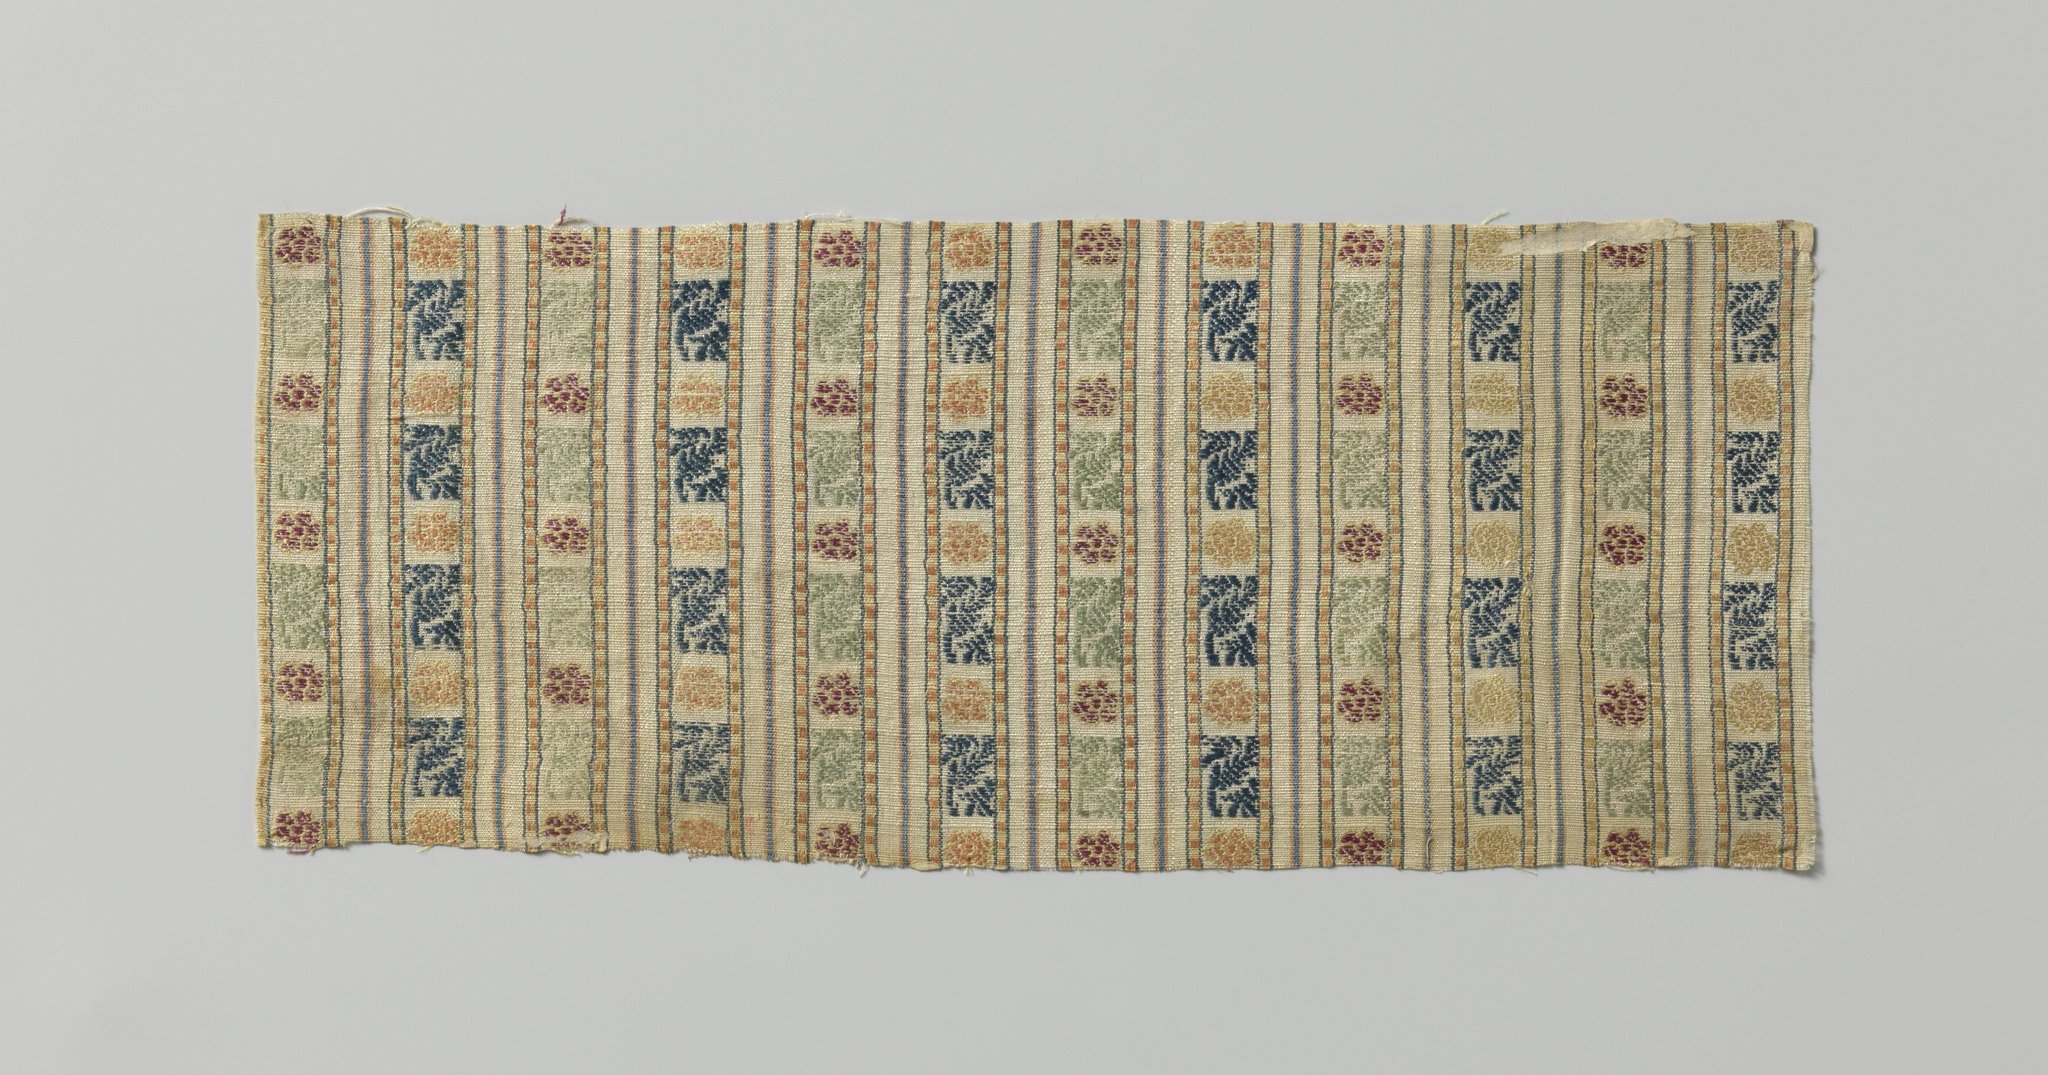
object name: fragment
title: Fragment Oosterse textiel met een veelkleurig gestreept patroon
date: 1800-1850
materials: cotton, silk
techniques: brocade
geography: india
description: Fragment Oosterse textiel met een veelkleurig gestreept patroon. Op een witte grond lopen banen waarin blokken met gestileerde bladeren afgewisseld door een bloem.